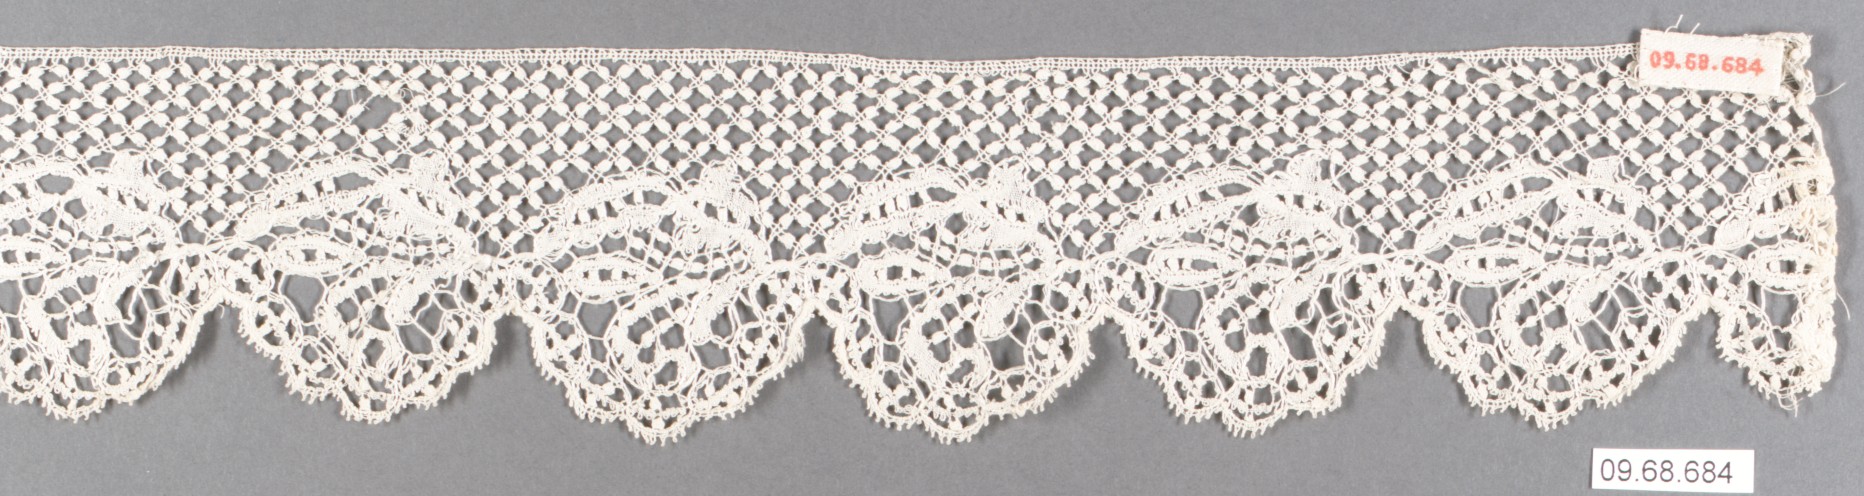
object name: strip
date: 1801-1900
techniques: lace